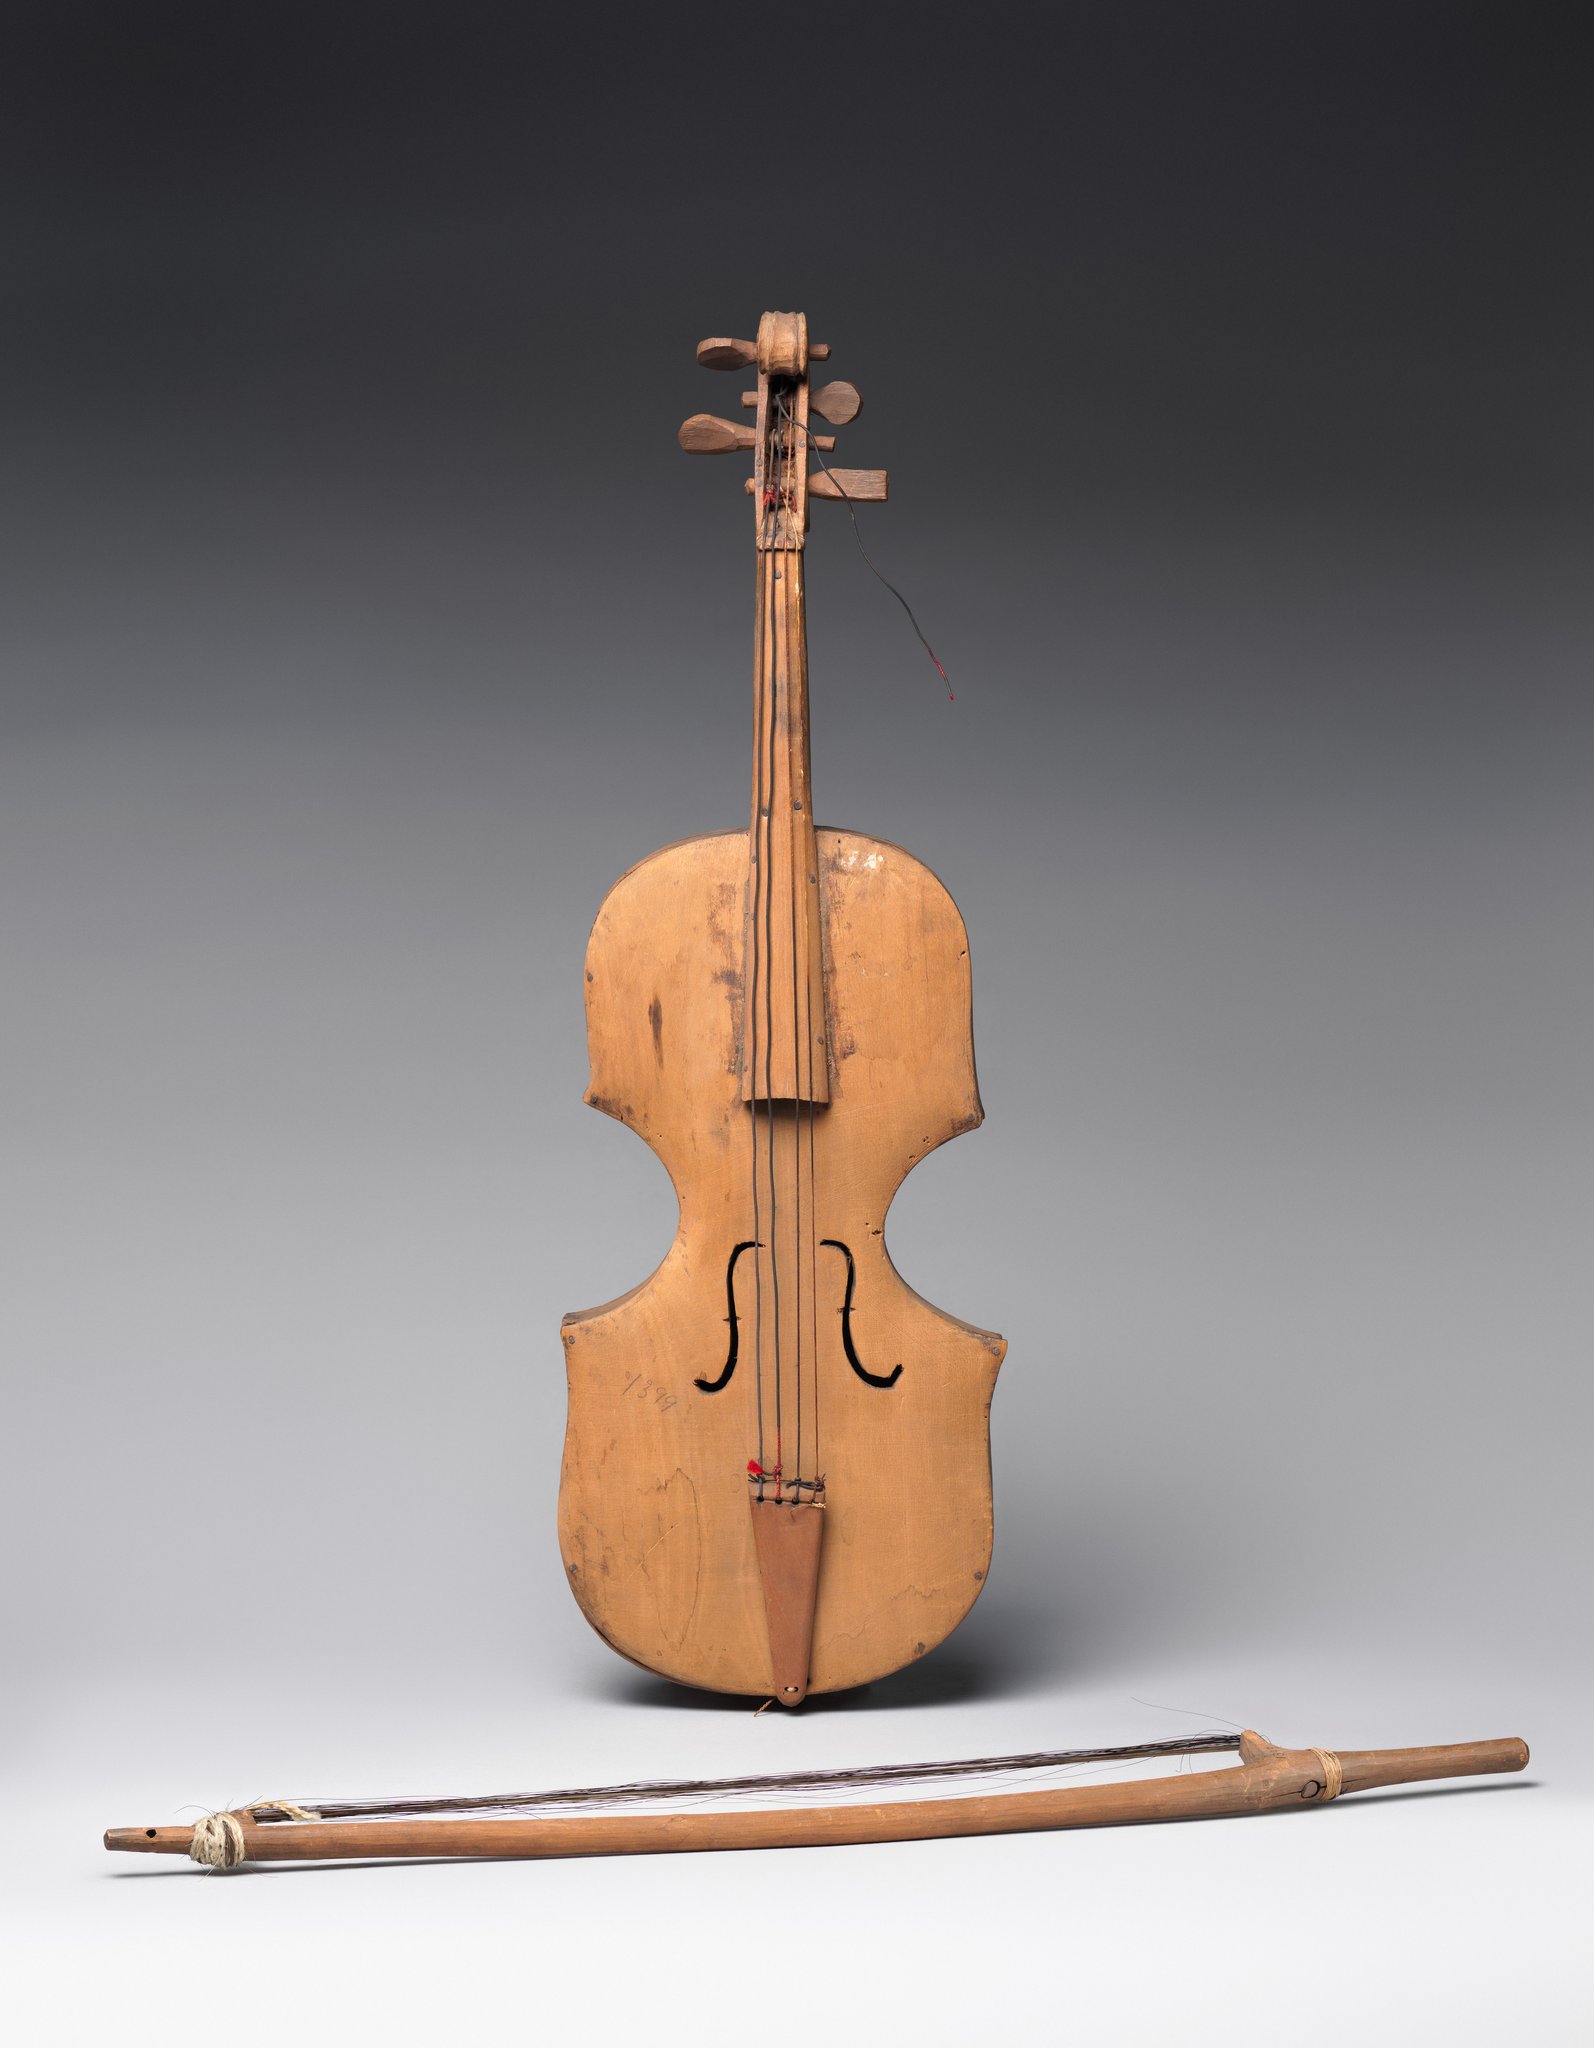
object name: violin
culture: melanesian, new ireland or papua new guinean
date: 1867-1900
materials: wood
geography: papua new guinea